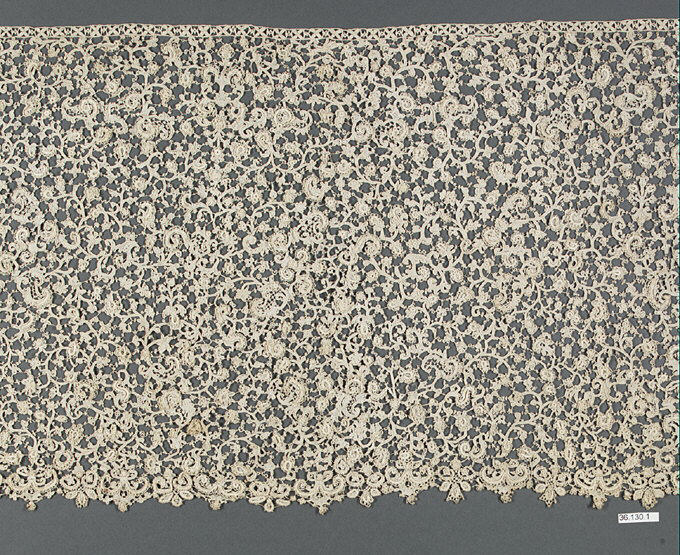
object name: flounce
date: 1601-1700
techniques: lace